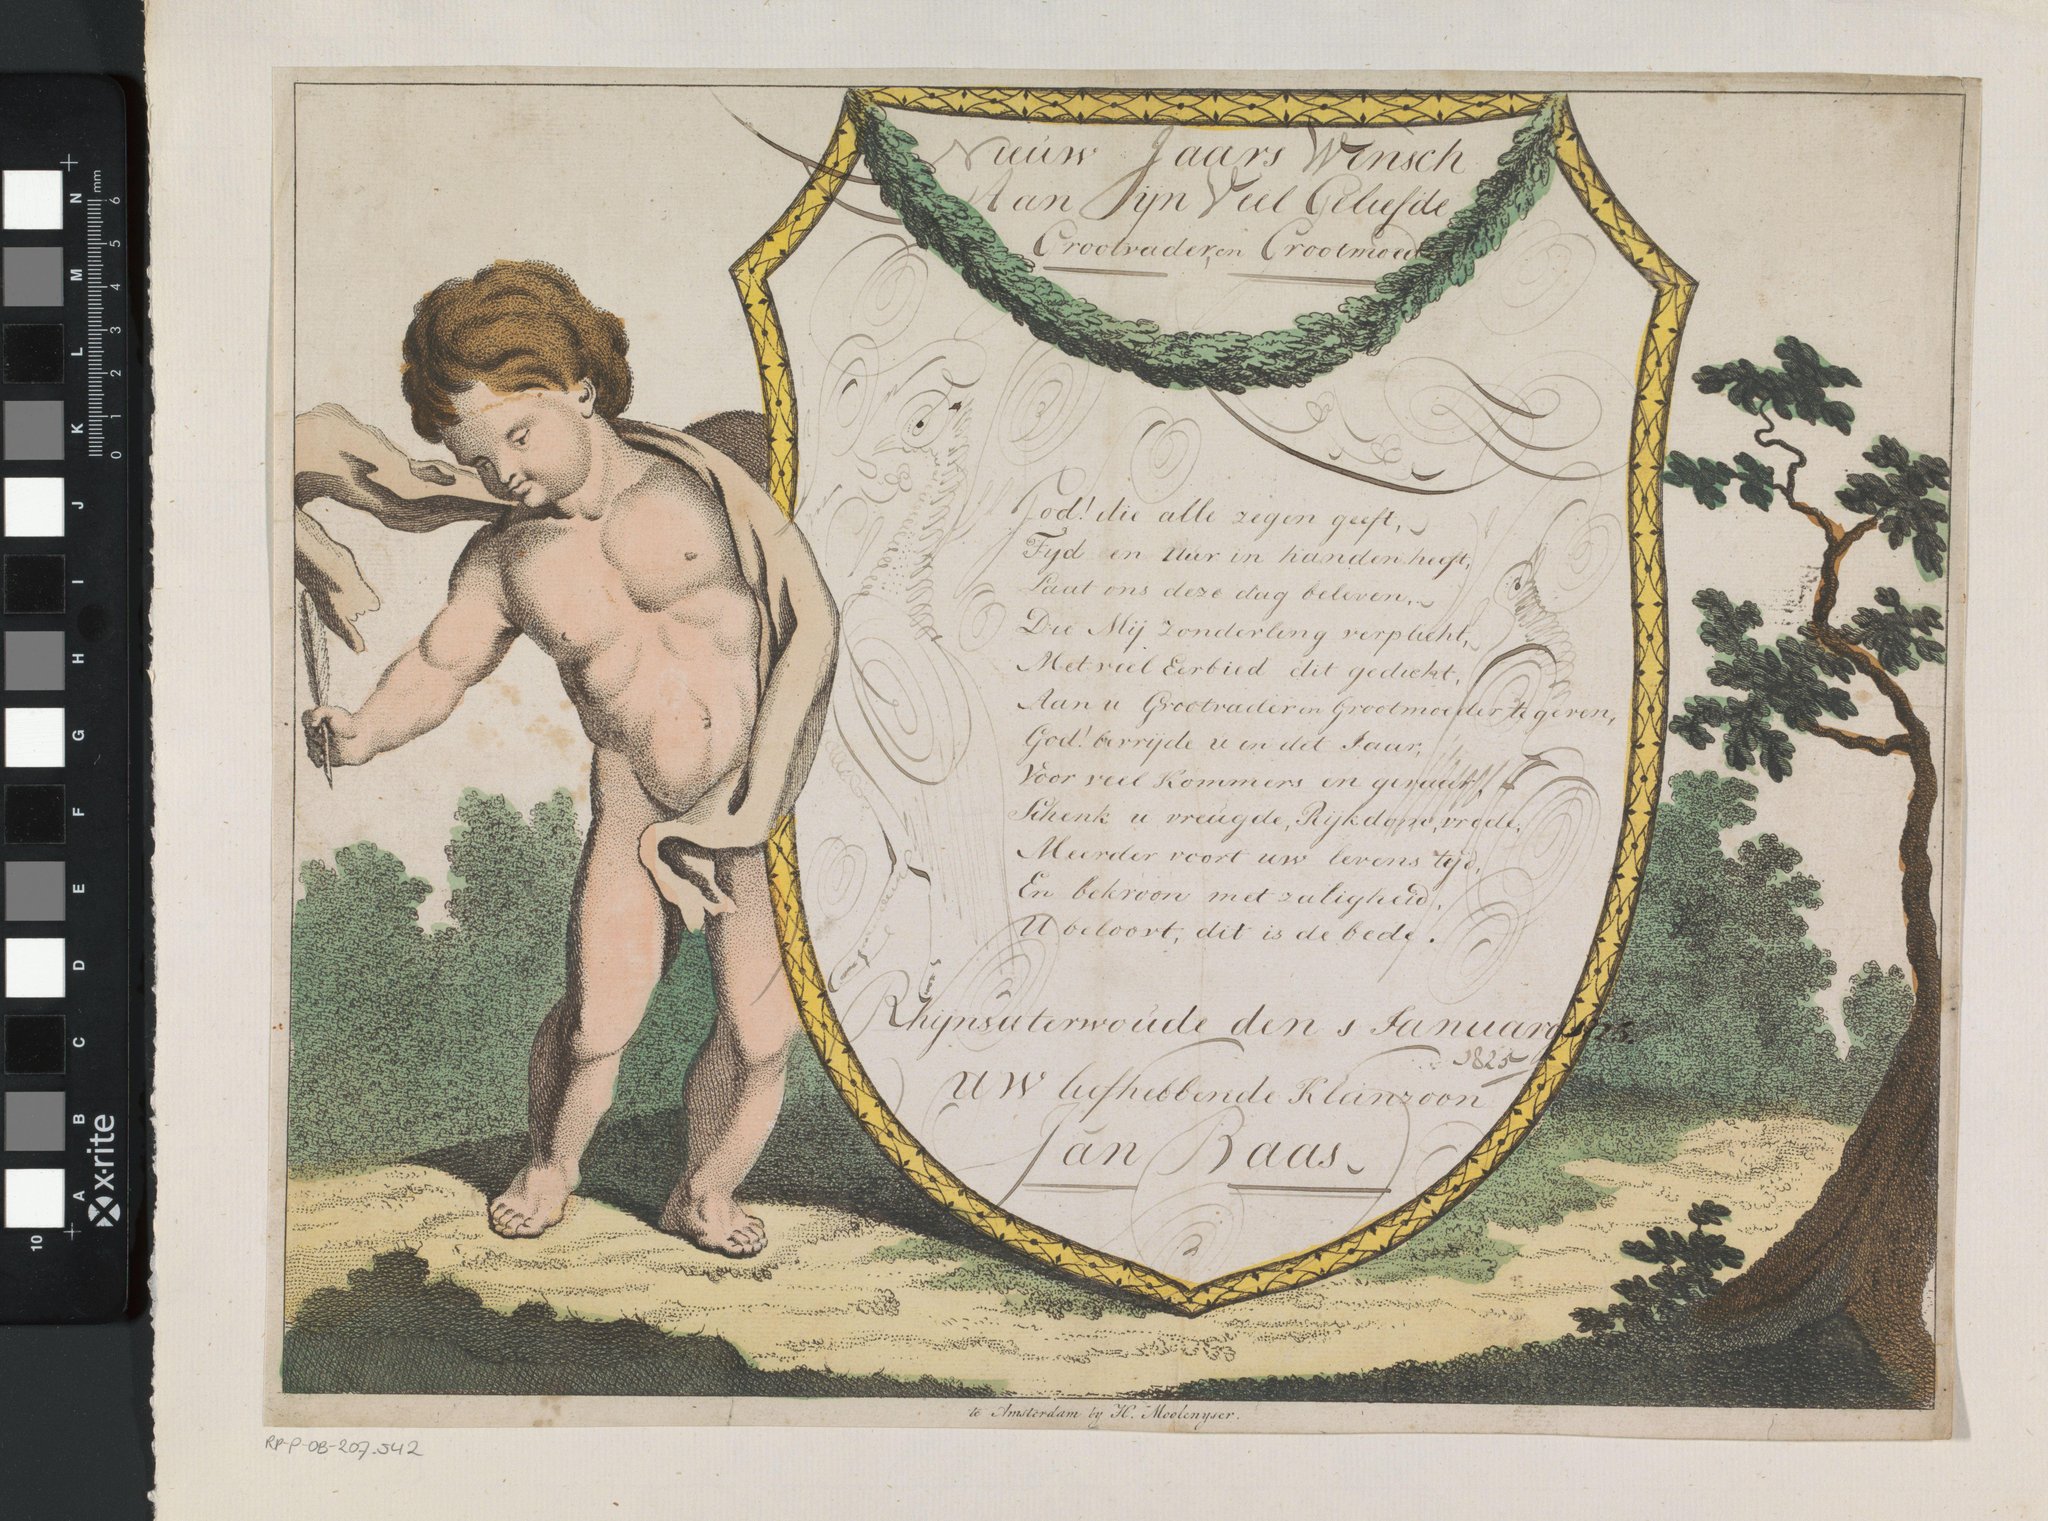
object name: print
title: Wensbrief met grote putto met schild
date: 1792-1847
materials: ink, paper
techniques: calligraphy, colour, etching, pen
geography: netherlands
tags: cupids: 'amores', 'amoretti', 'putti'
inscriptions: inscription: ‘Nieuw jaars wensch / Aan mijn veel geliefde / Grootvader en grootmoeder / God! die alle zegen geeft ...’, collector's mark: Lugt 2760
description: Wensbrief met beschreven cartouche binnen een decoratief kader met een voorstelling van een grote putto met schild. Handgeschreven bericht in kalligrafie (Nieuwjaarswens) door Jan Baas aan zijn grootvader en grootmoeder.